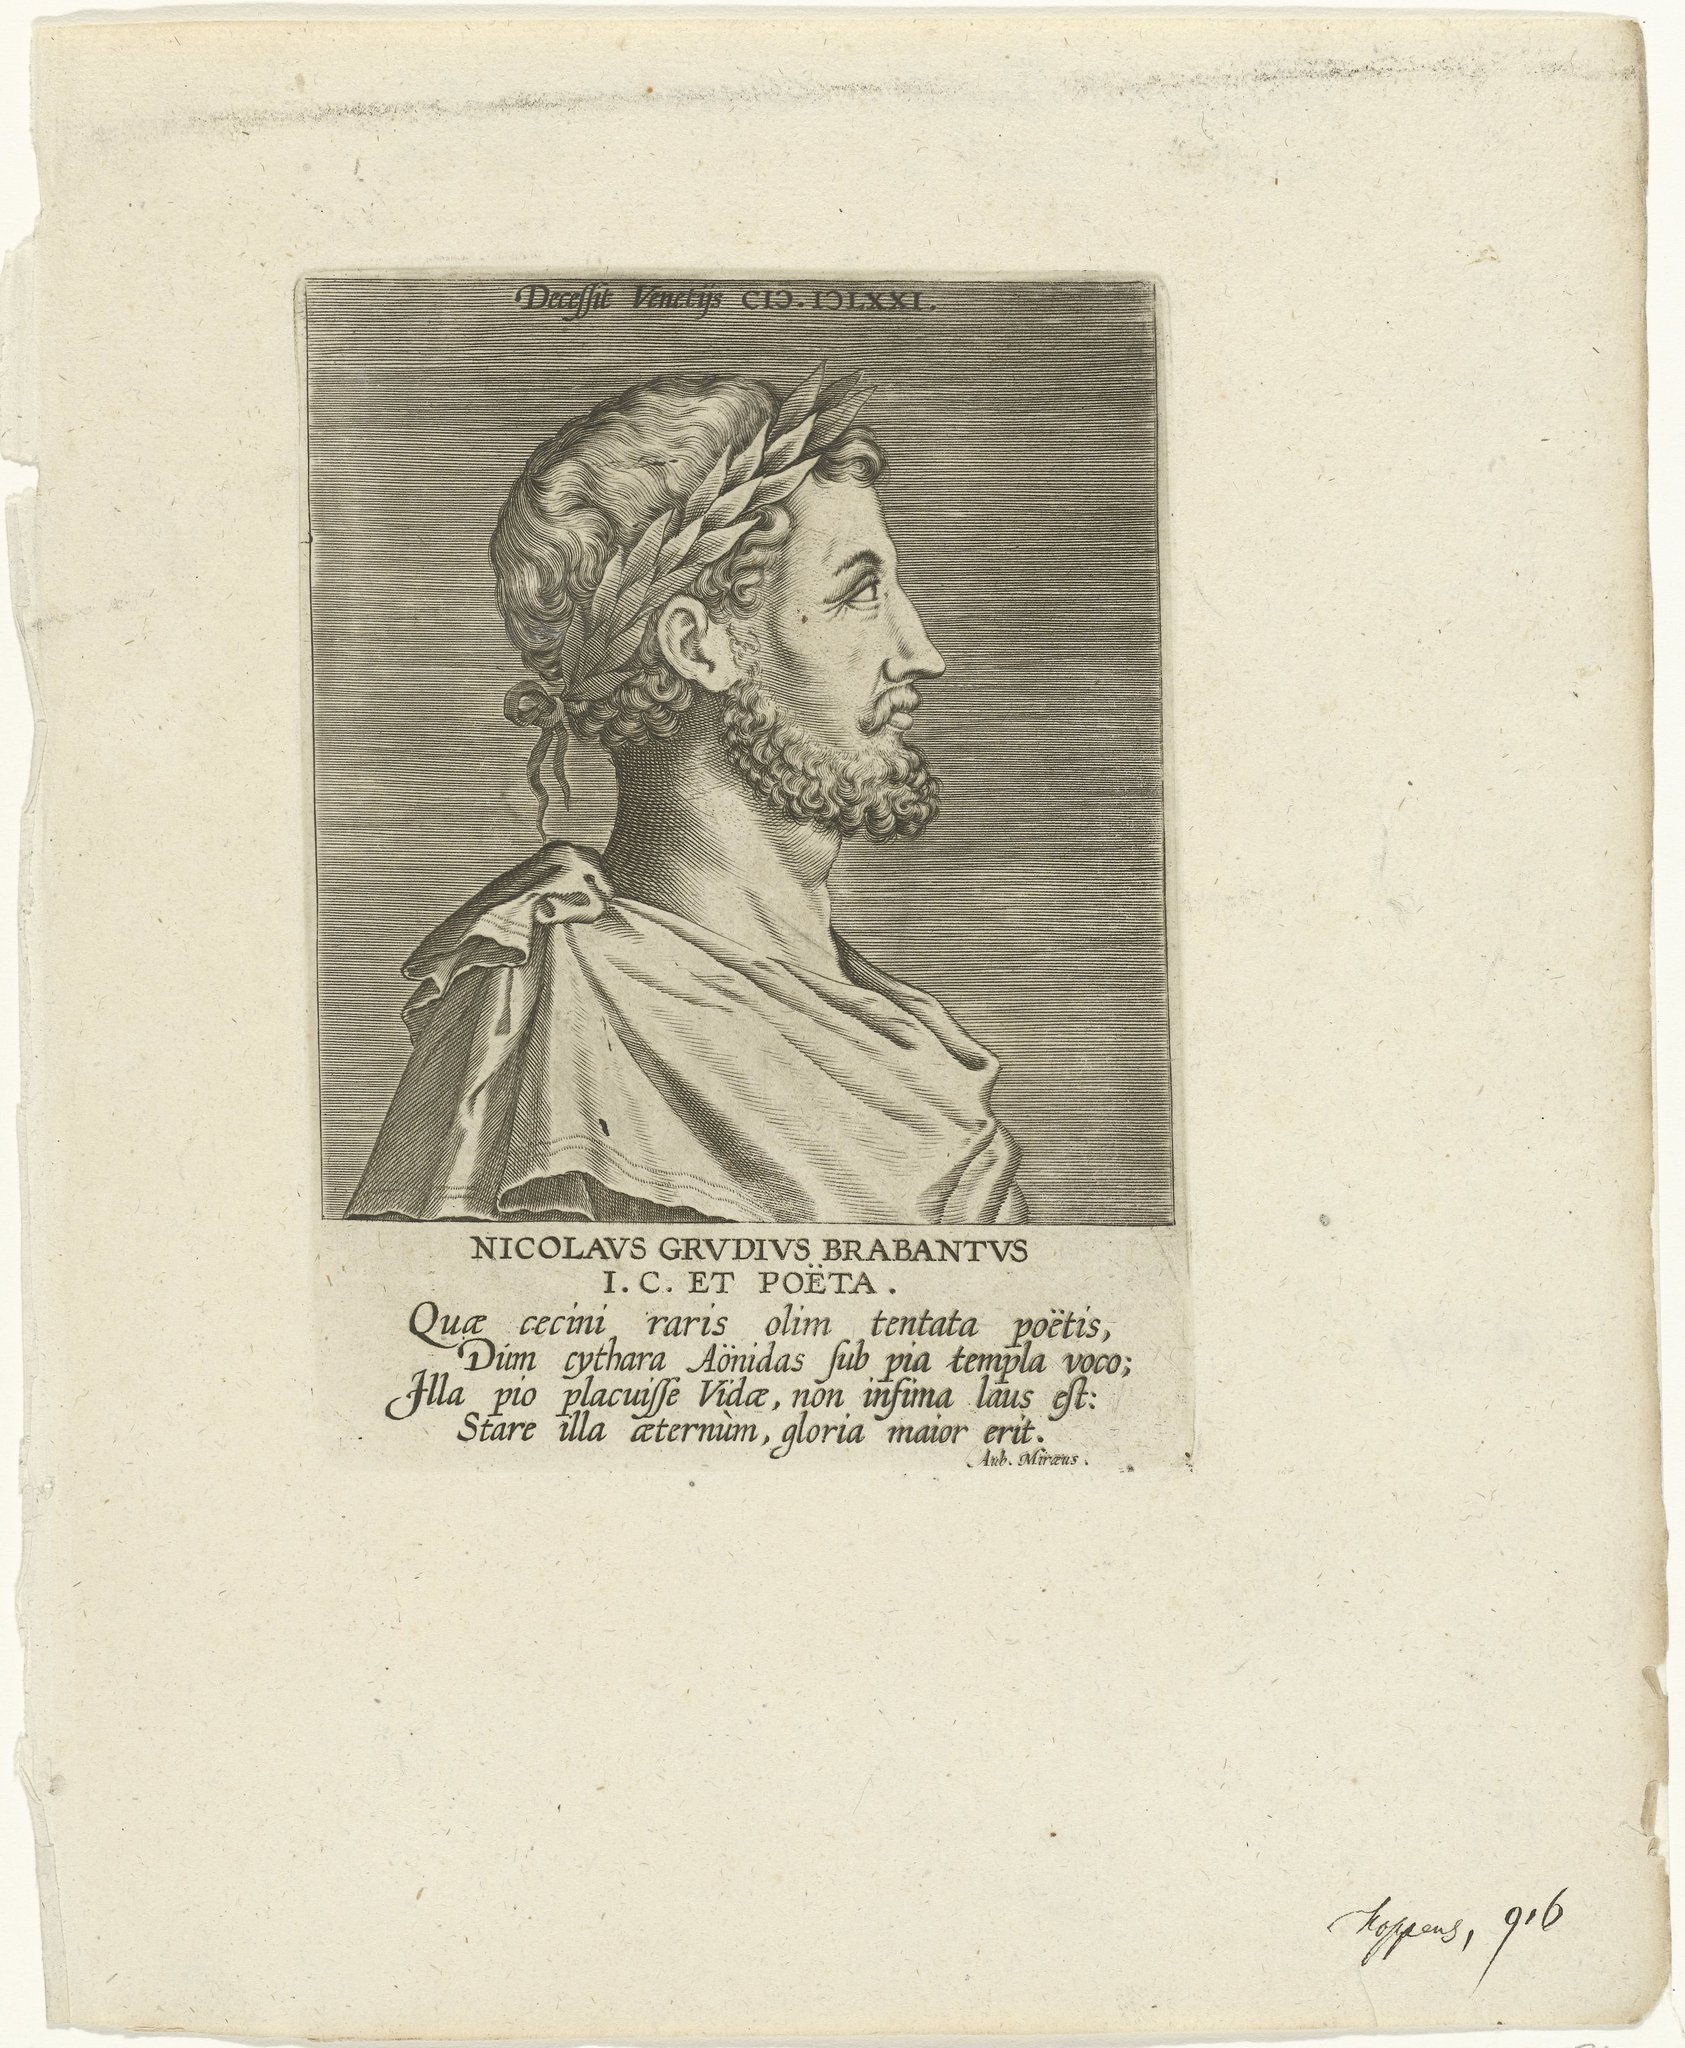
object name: print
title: Nicolavs Grvdivs Brabantvs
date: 1604-1608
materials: paper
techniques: engraving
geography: antwerp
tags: dichter, nicolaus grudius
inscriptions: caption: ‘Foppens 916’, collector's mark: Lugt 2228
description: Portret van Nicolaas Grudius, Leuvense dichter en humanist. In profiel naar rechts. De prent heeft een Latijns boven- en onderschrift en maakt deel uit van een serie van bekende schrijvers uit de Nederlanden.